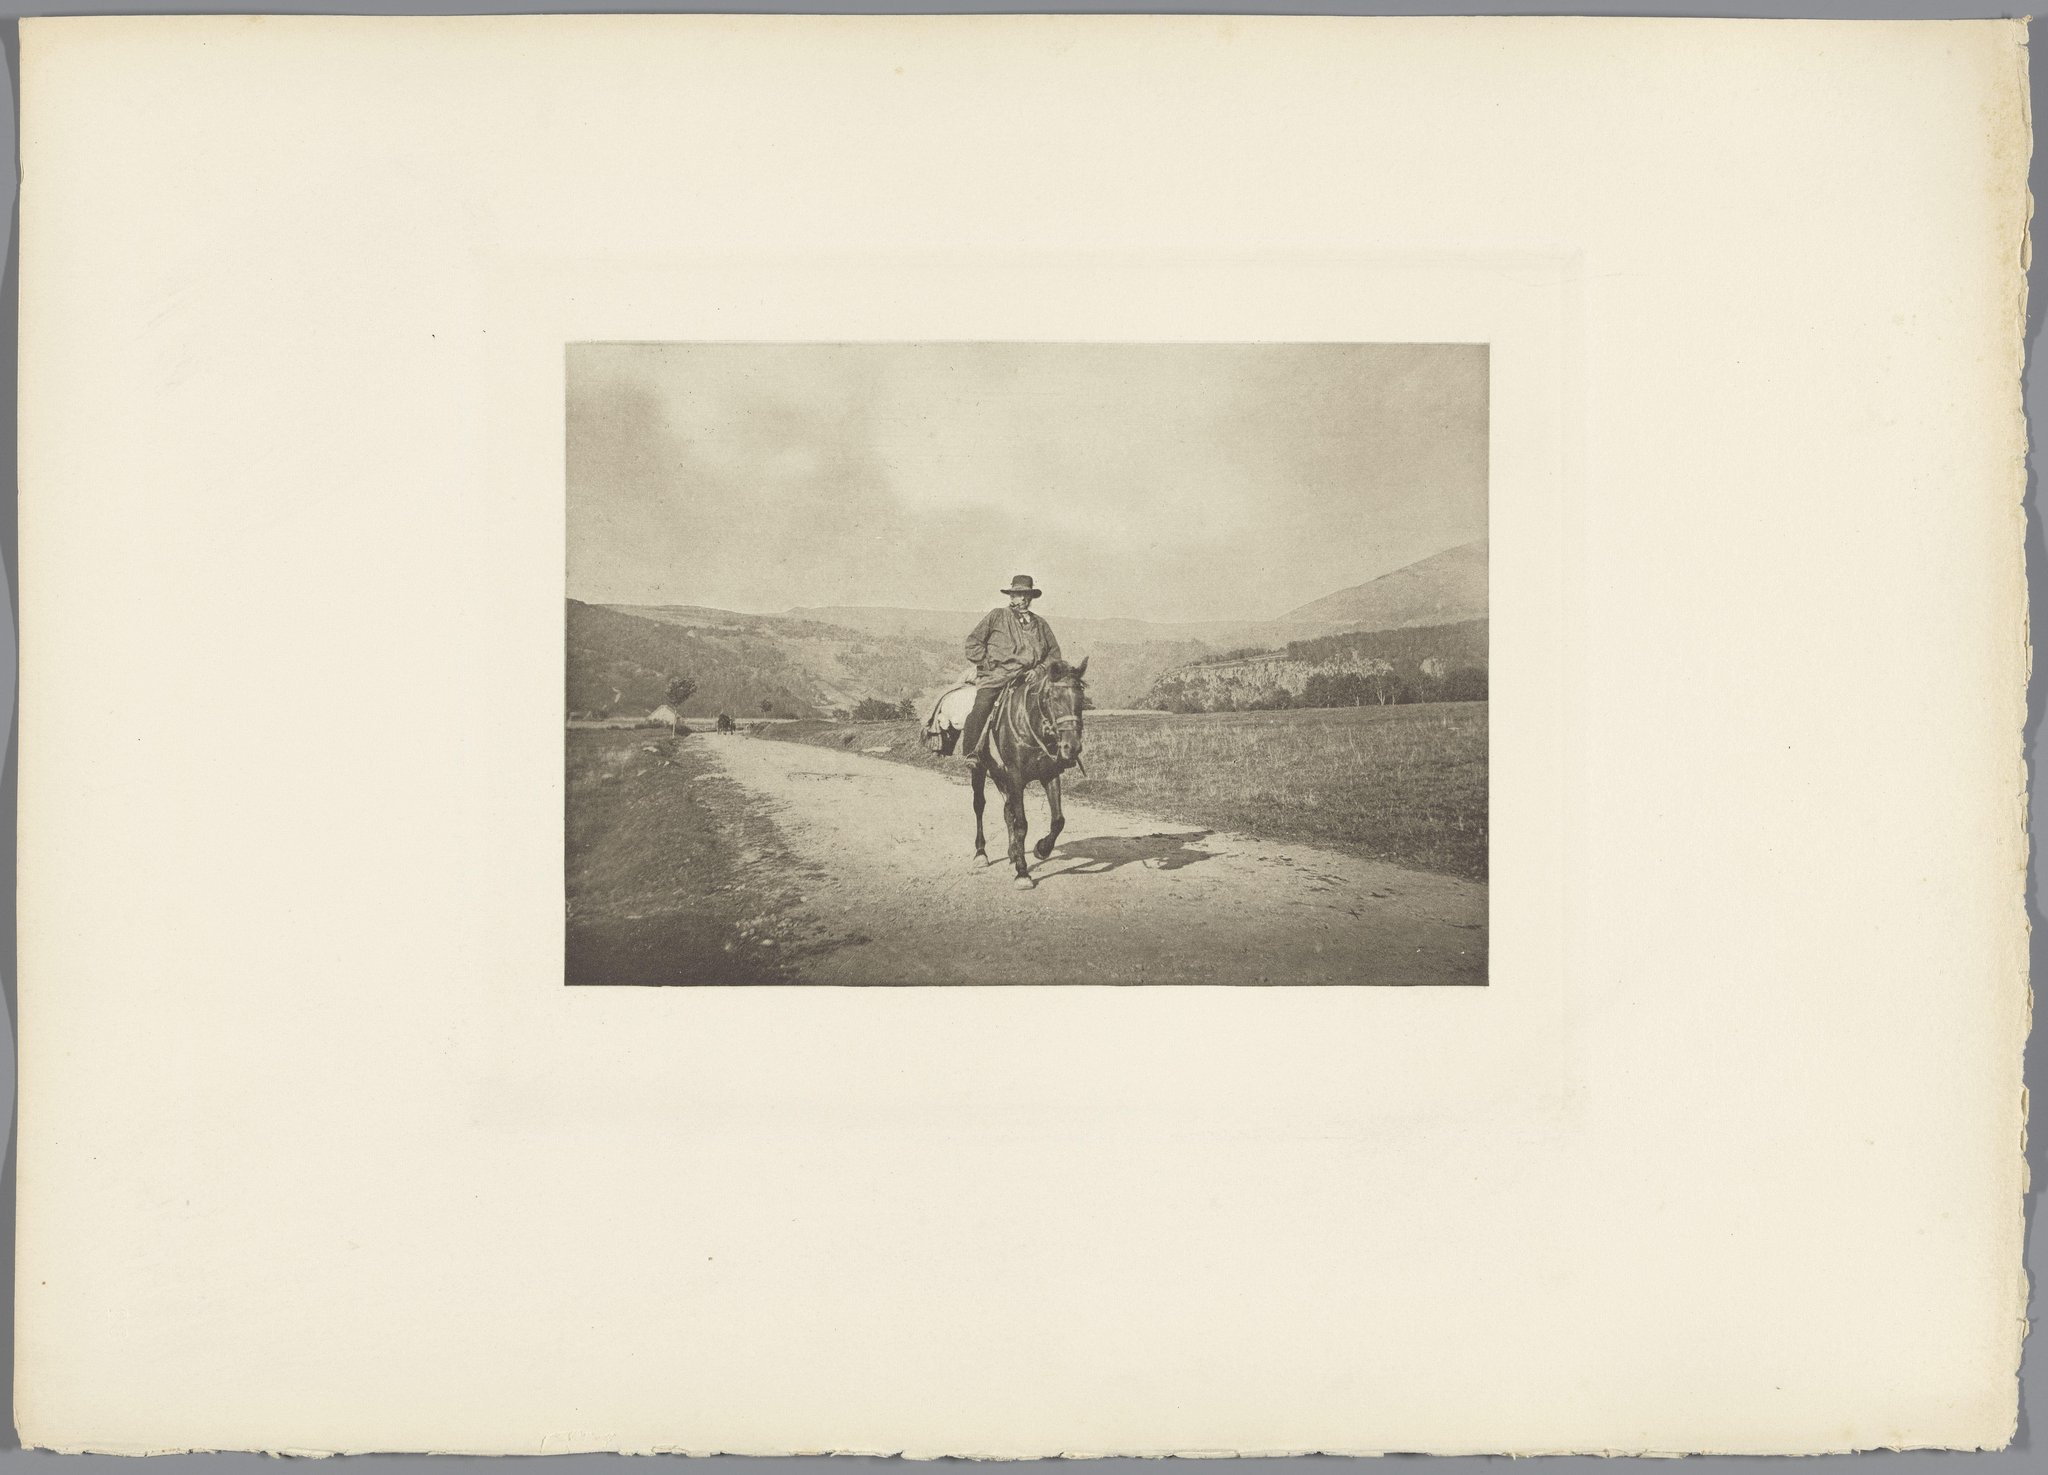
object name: photomechanical print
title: Retour du Moulin (Mont-Dore)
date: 1891-1896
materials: paper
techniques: photoaquatint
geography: paris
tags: riding a horse, ass, or mule; rider, horseman, (high) hill